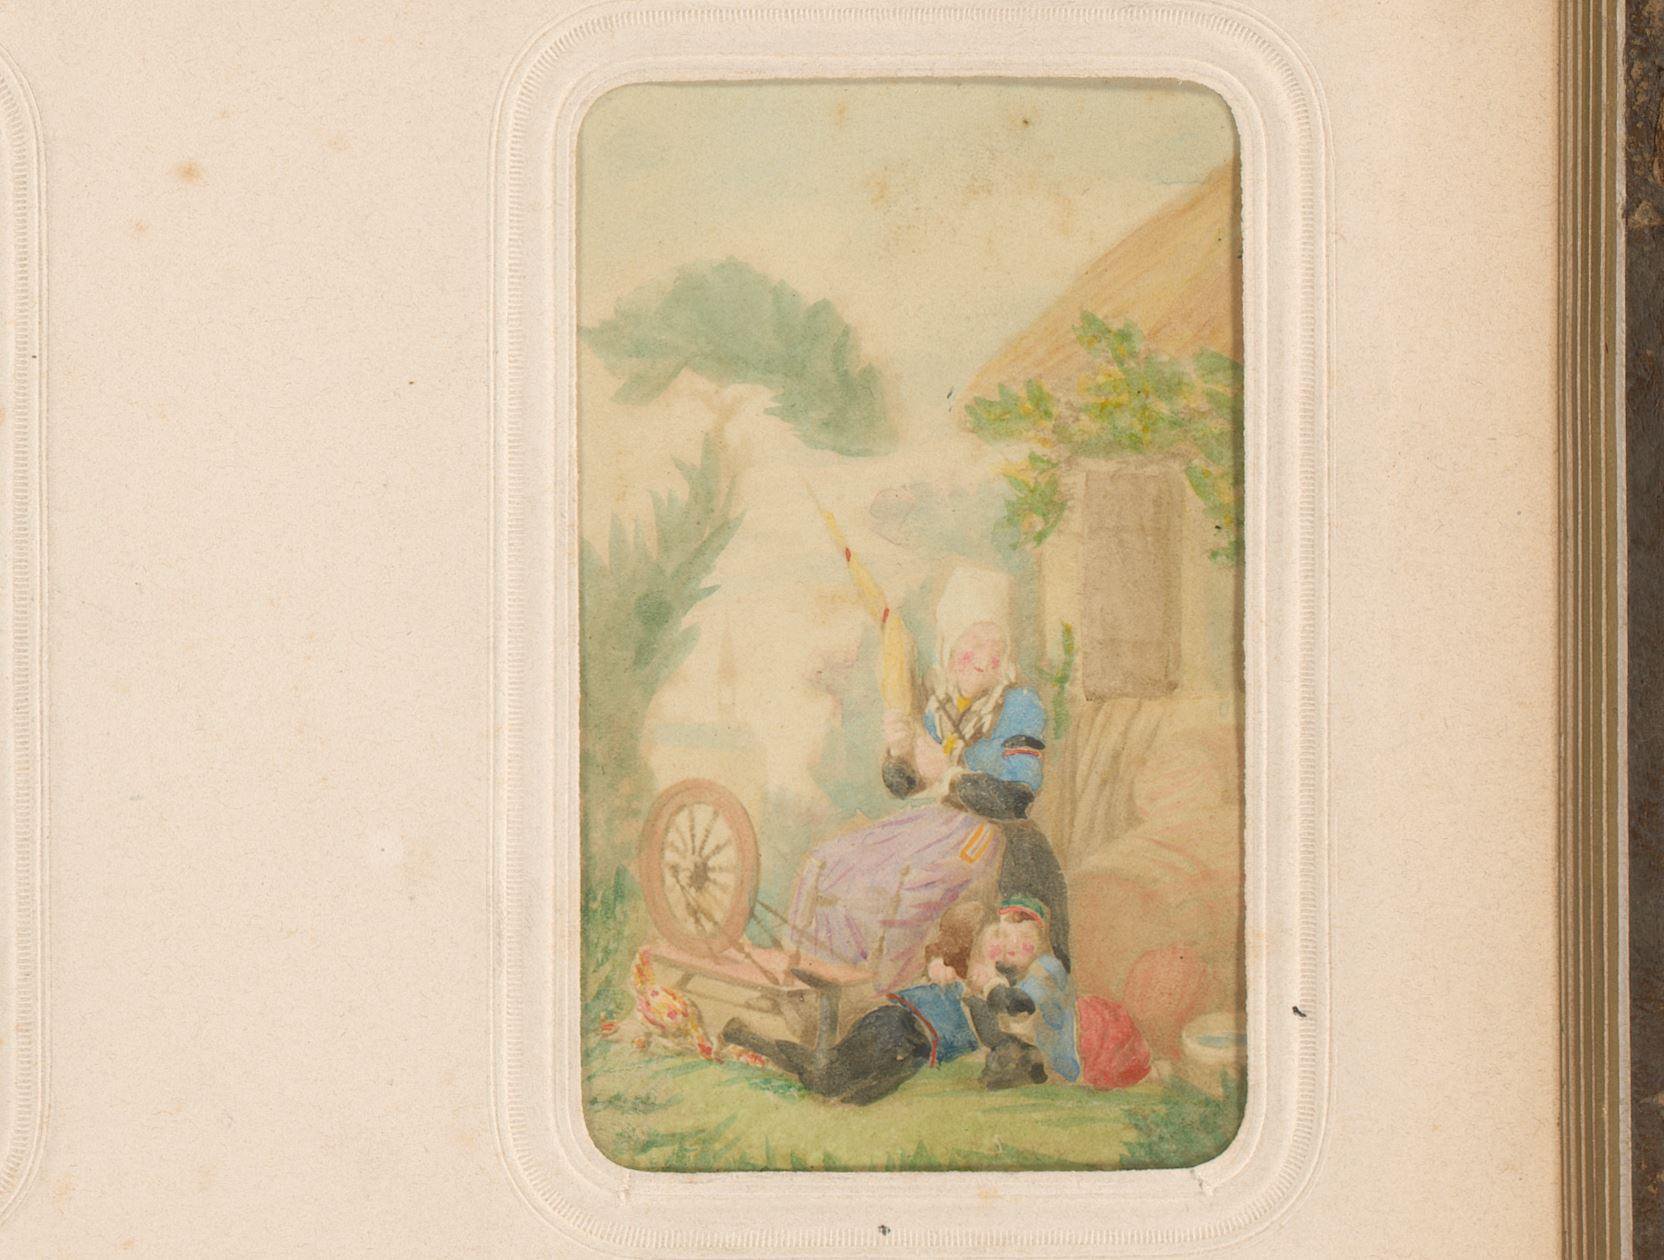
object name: album leaf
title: Fotoreproductie van een prent van een vrouw met spinnewiel en twee kinderen, buiten voor een woning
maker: théodore lemonnier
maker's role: fotograaf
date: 1860-1900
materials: cardboard, photographic support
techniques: albumen print, hand coloring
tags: spinning-wheel, mother and child(ren), woman and child(ren) (family group)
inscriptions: inscription: ‘Photographie Artistique/ Lemonnier Théodore./ Rue Bréa, 7/ Quartier du Luxembourg/ Paris.’, annotation: ‘[...]’, annotation: ‘2 [...] 74’